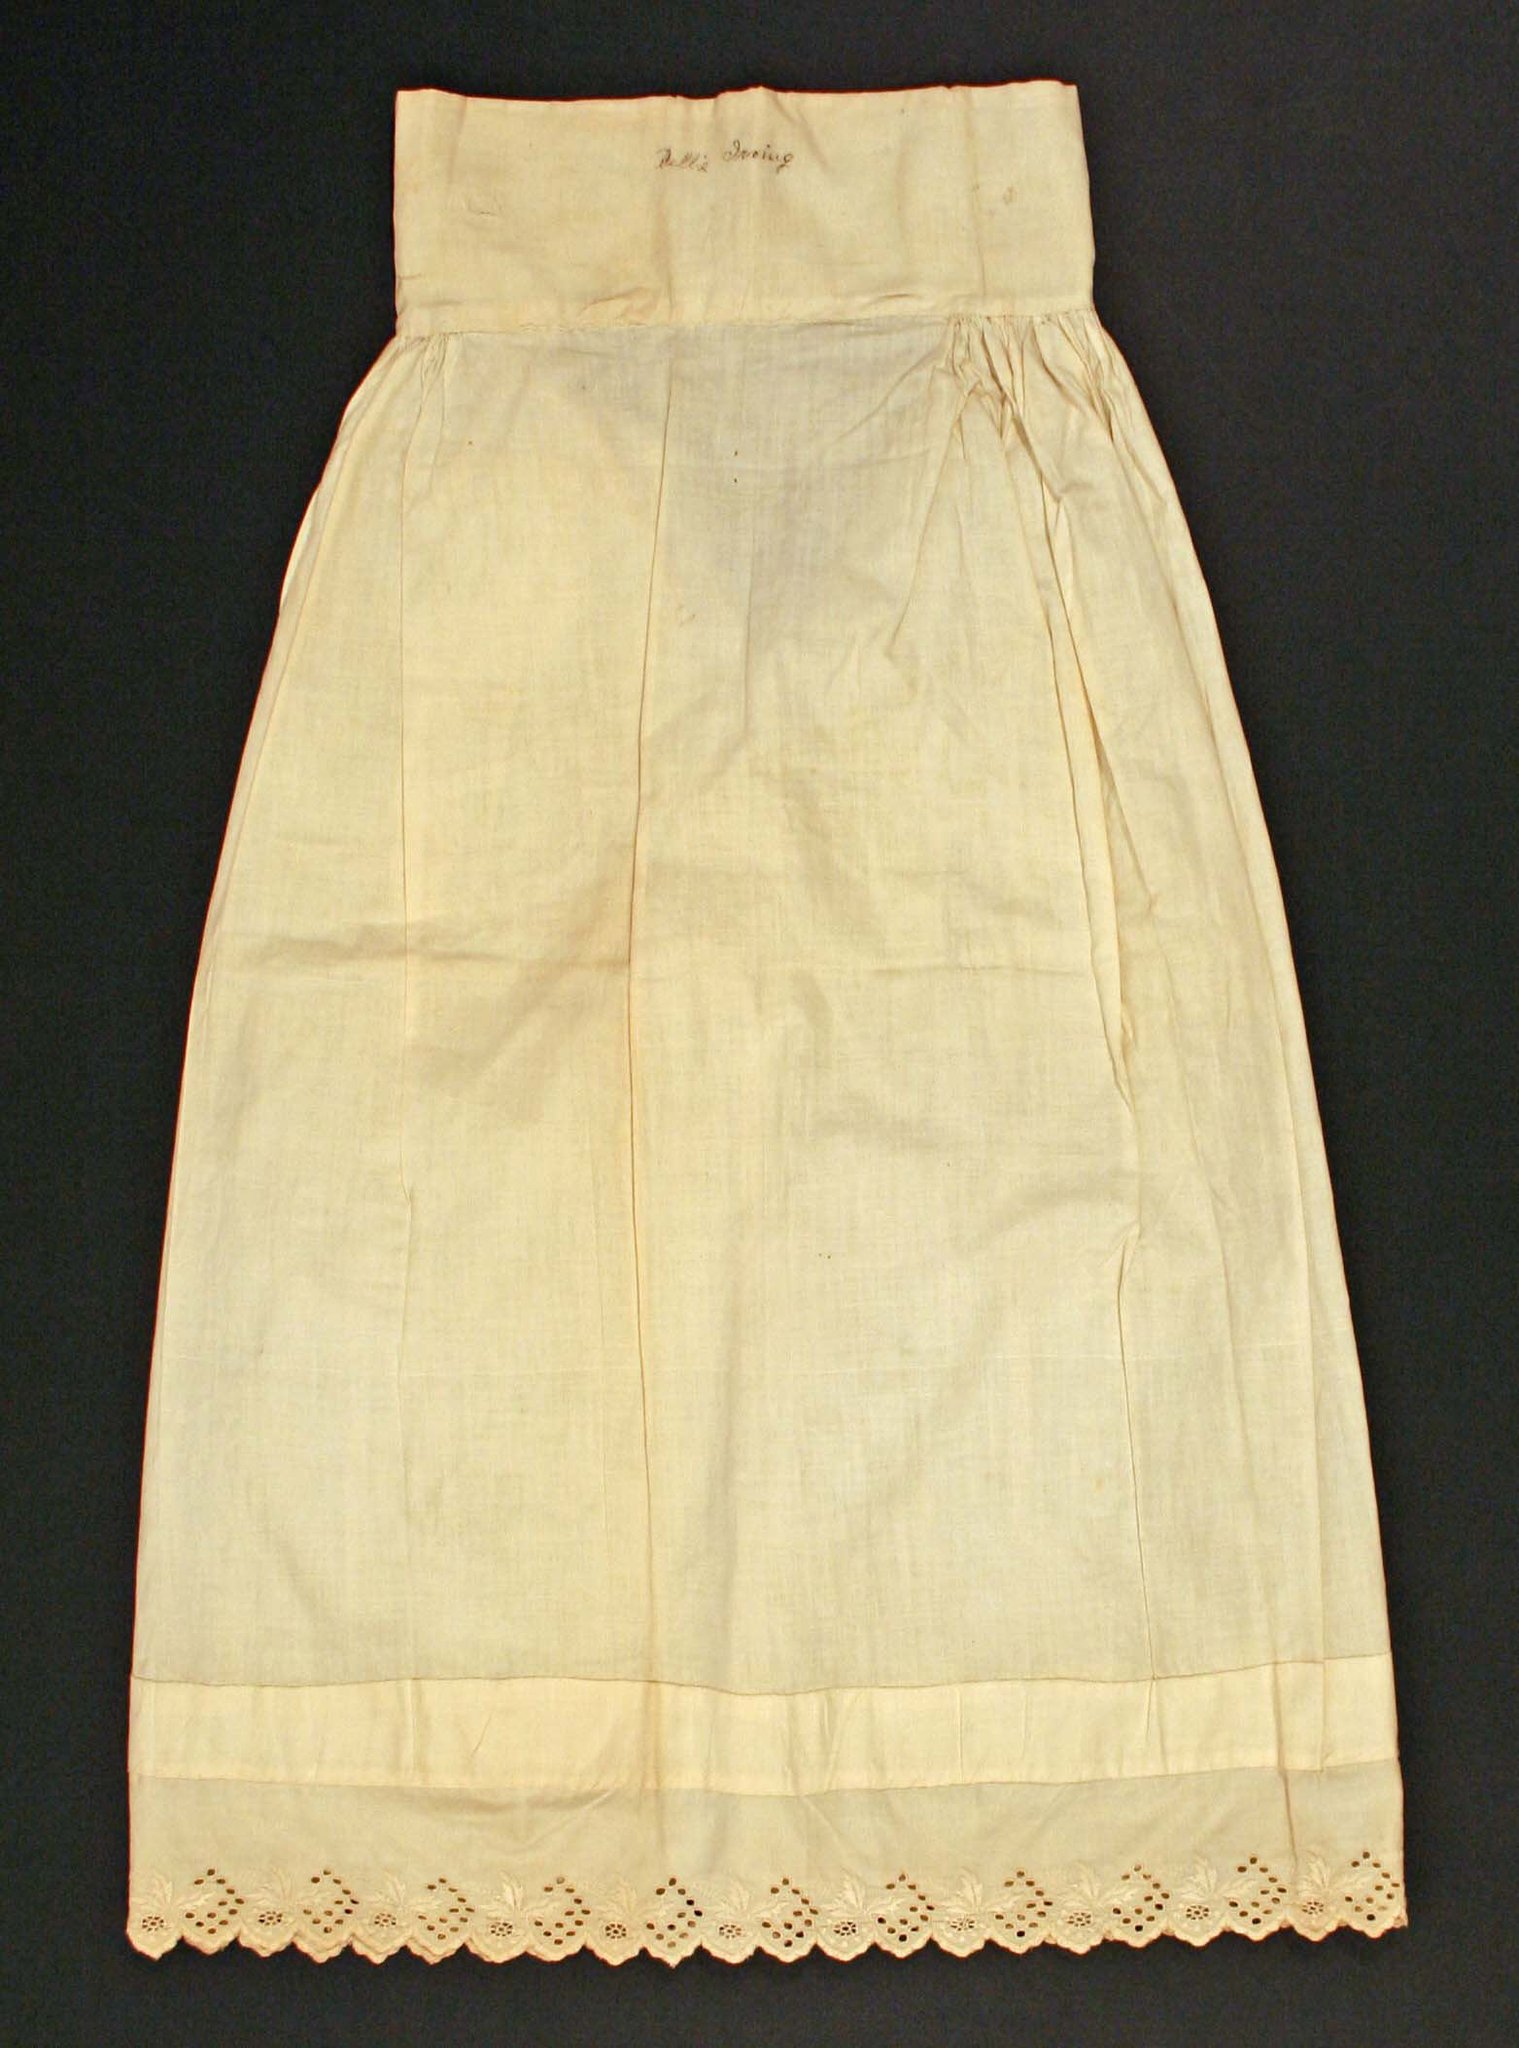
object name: underskirt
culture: american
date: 1865